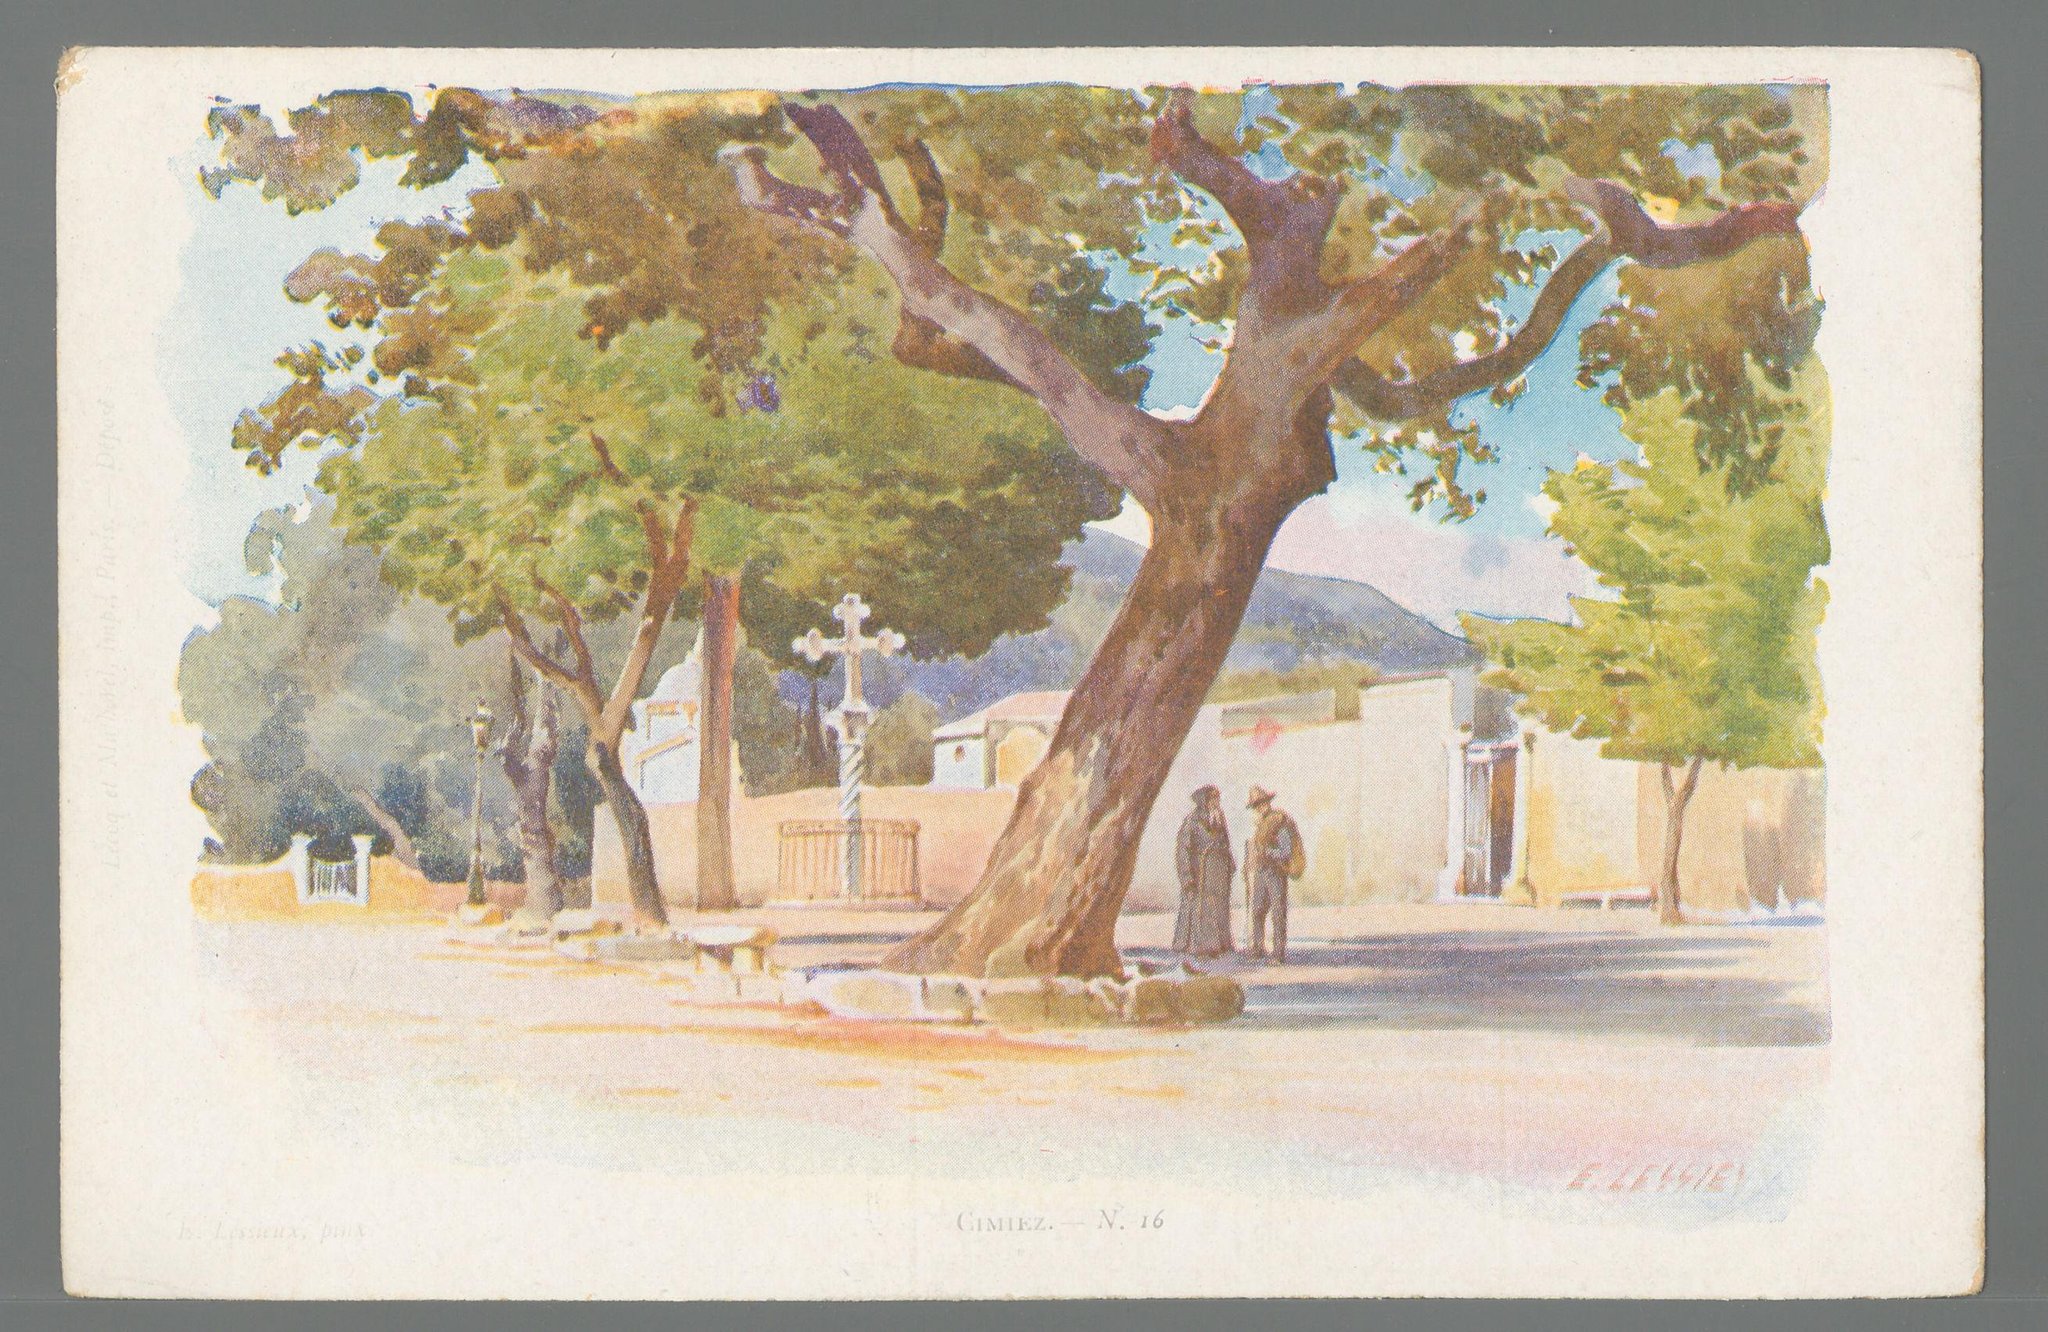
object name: reproduction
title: Cimiez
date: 1892-1904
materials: cardboard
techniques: writing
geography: paris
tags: trees, street (+ city(-scape) with figures, staffage)